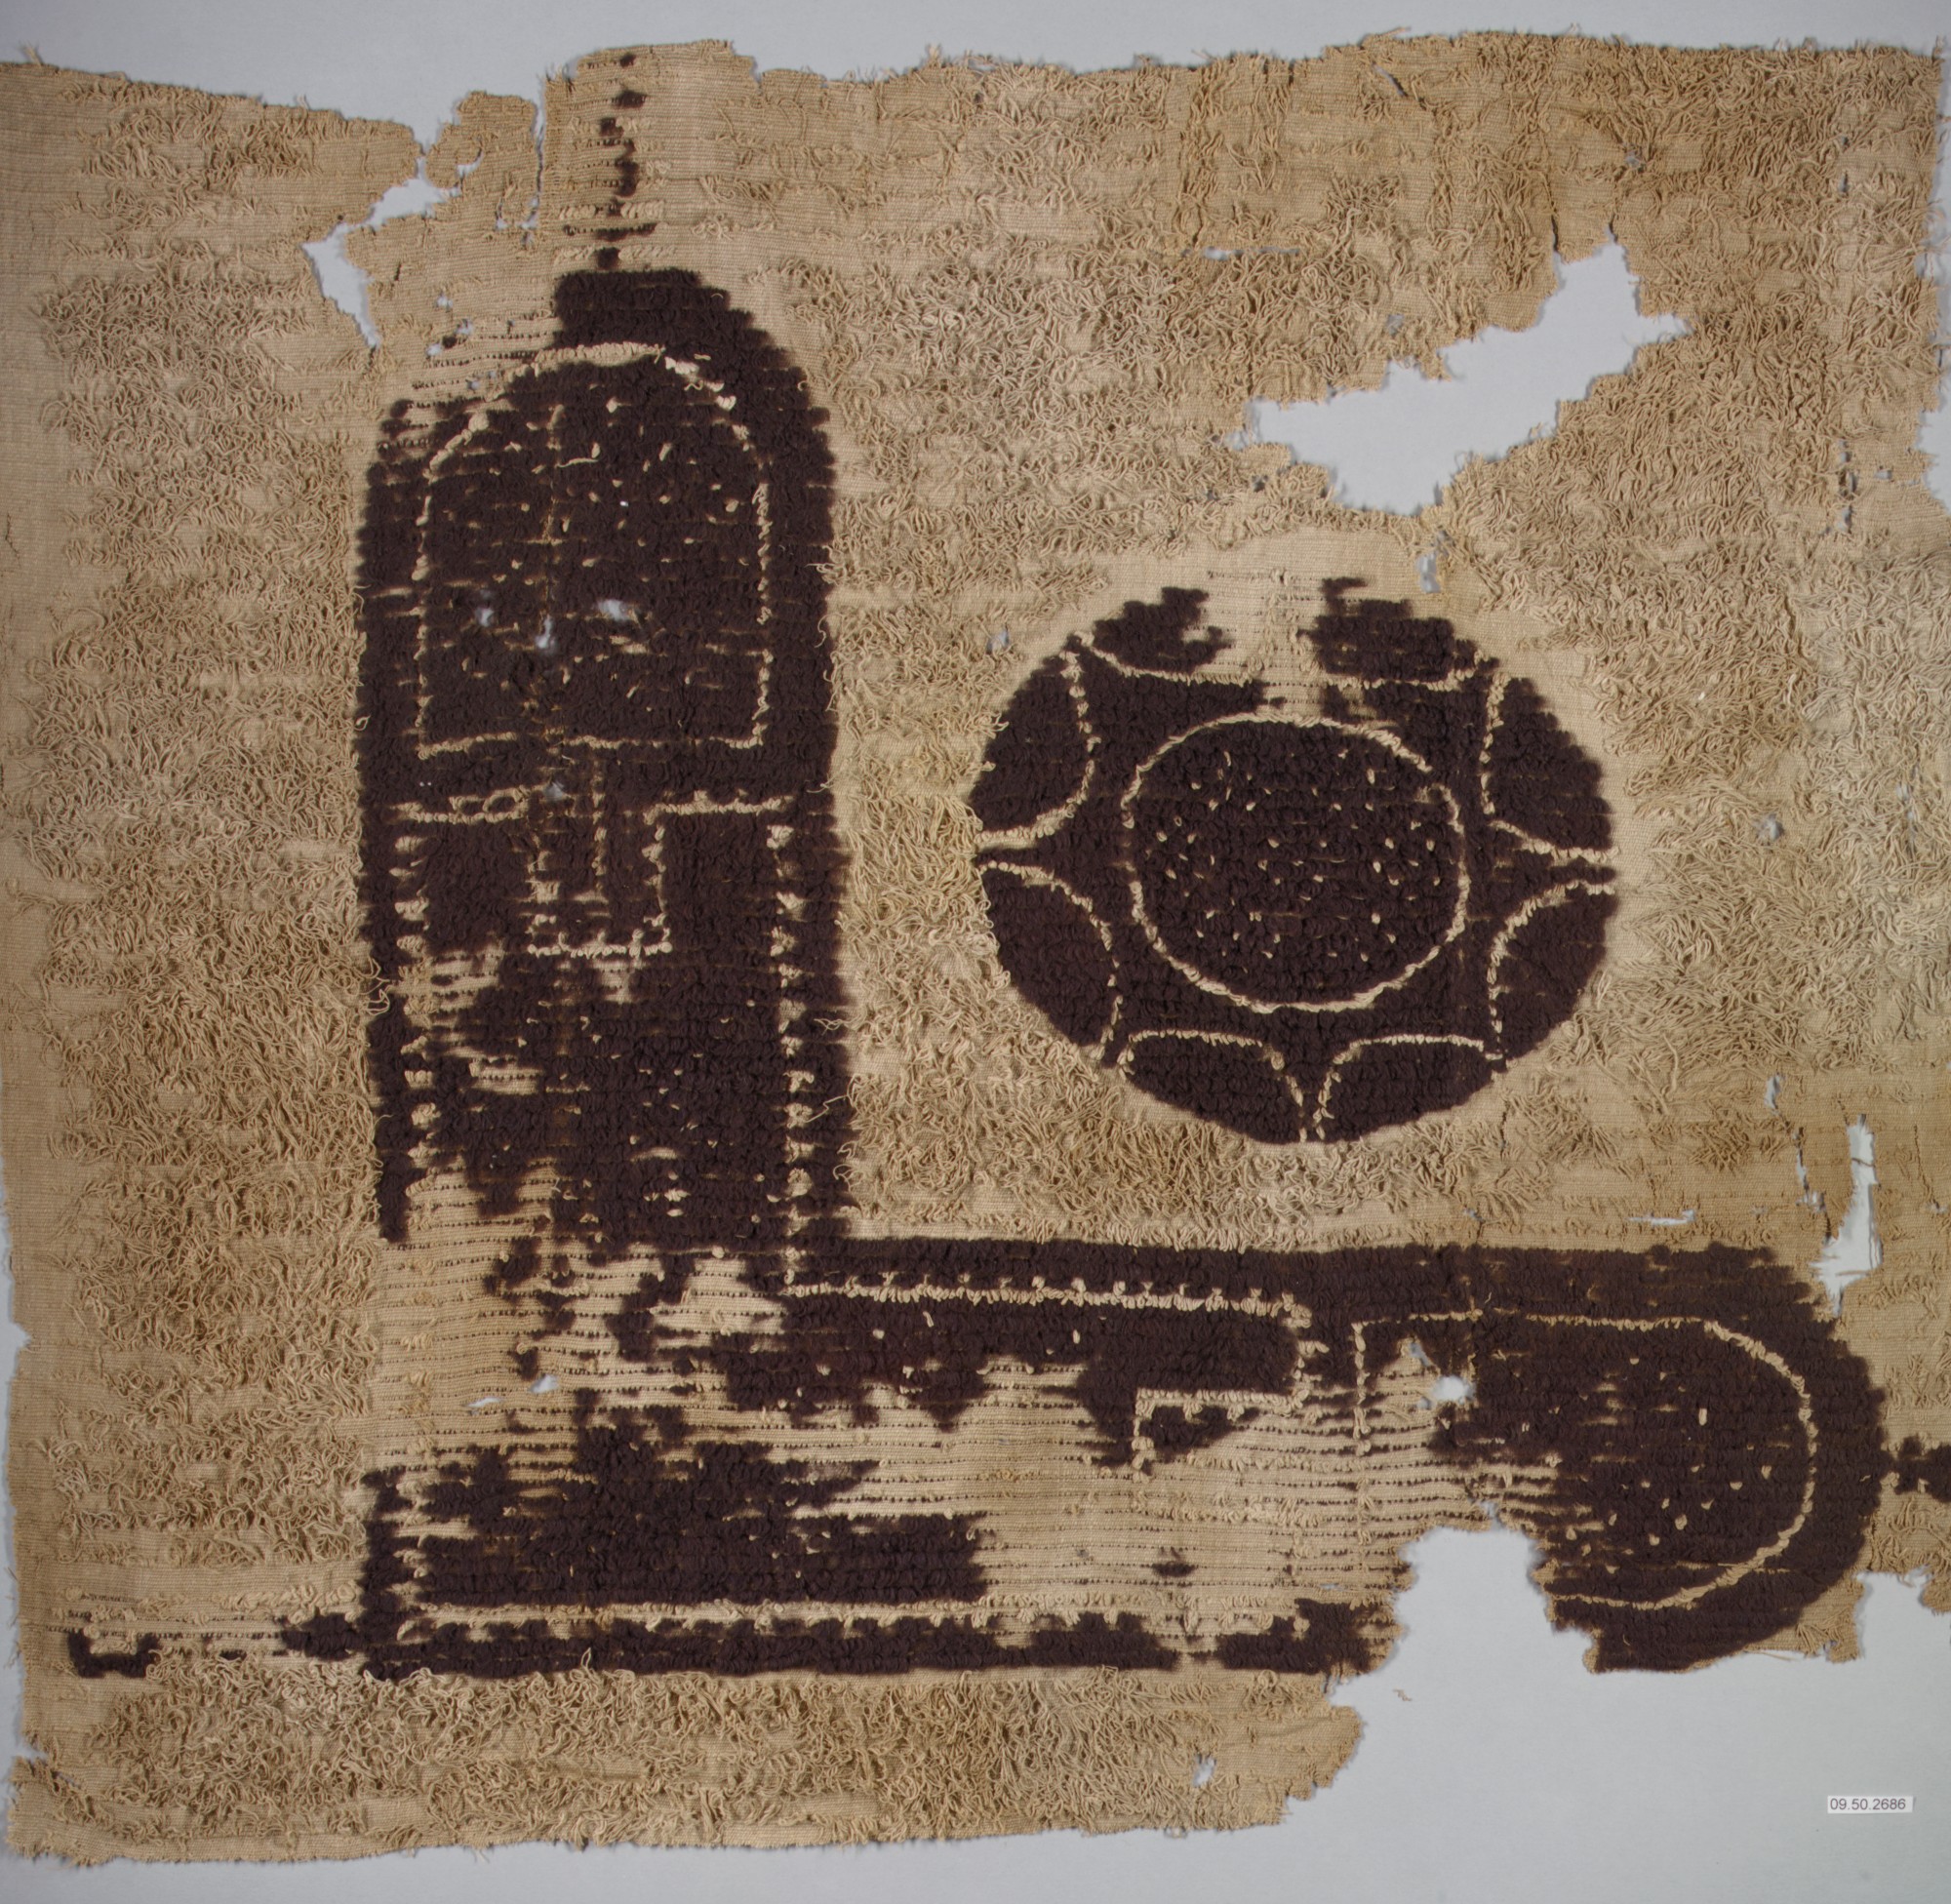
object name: fragment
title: Textile Fragment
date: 201-400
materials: linen, wool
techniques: embroidery, weave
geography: egypt